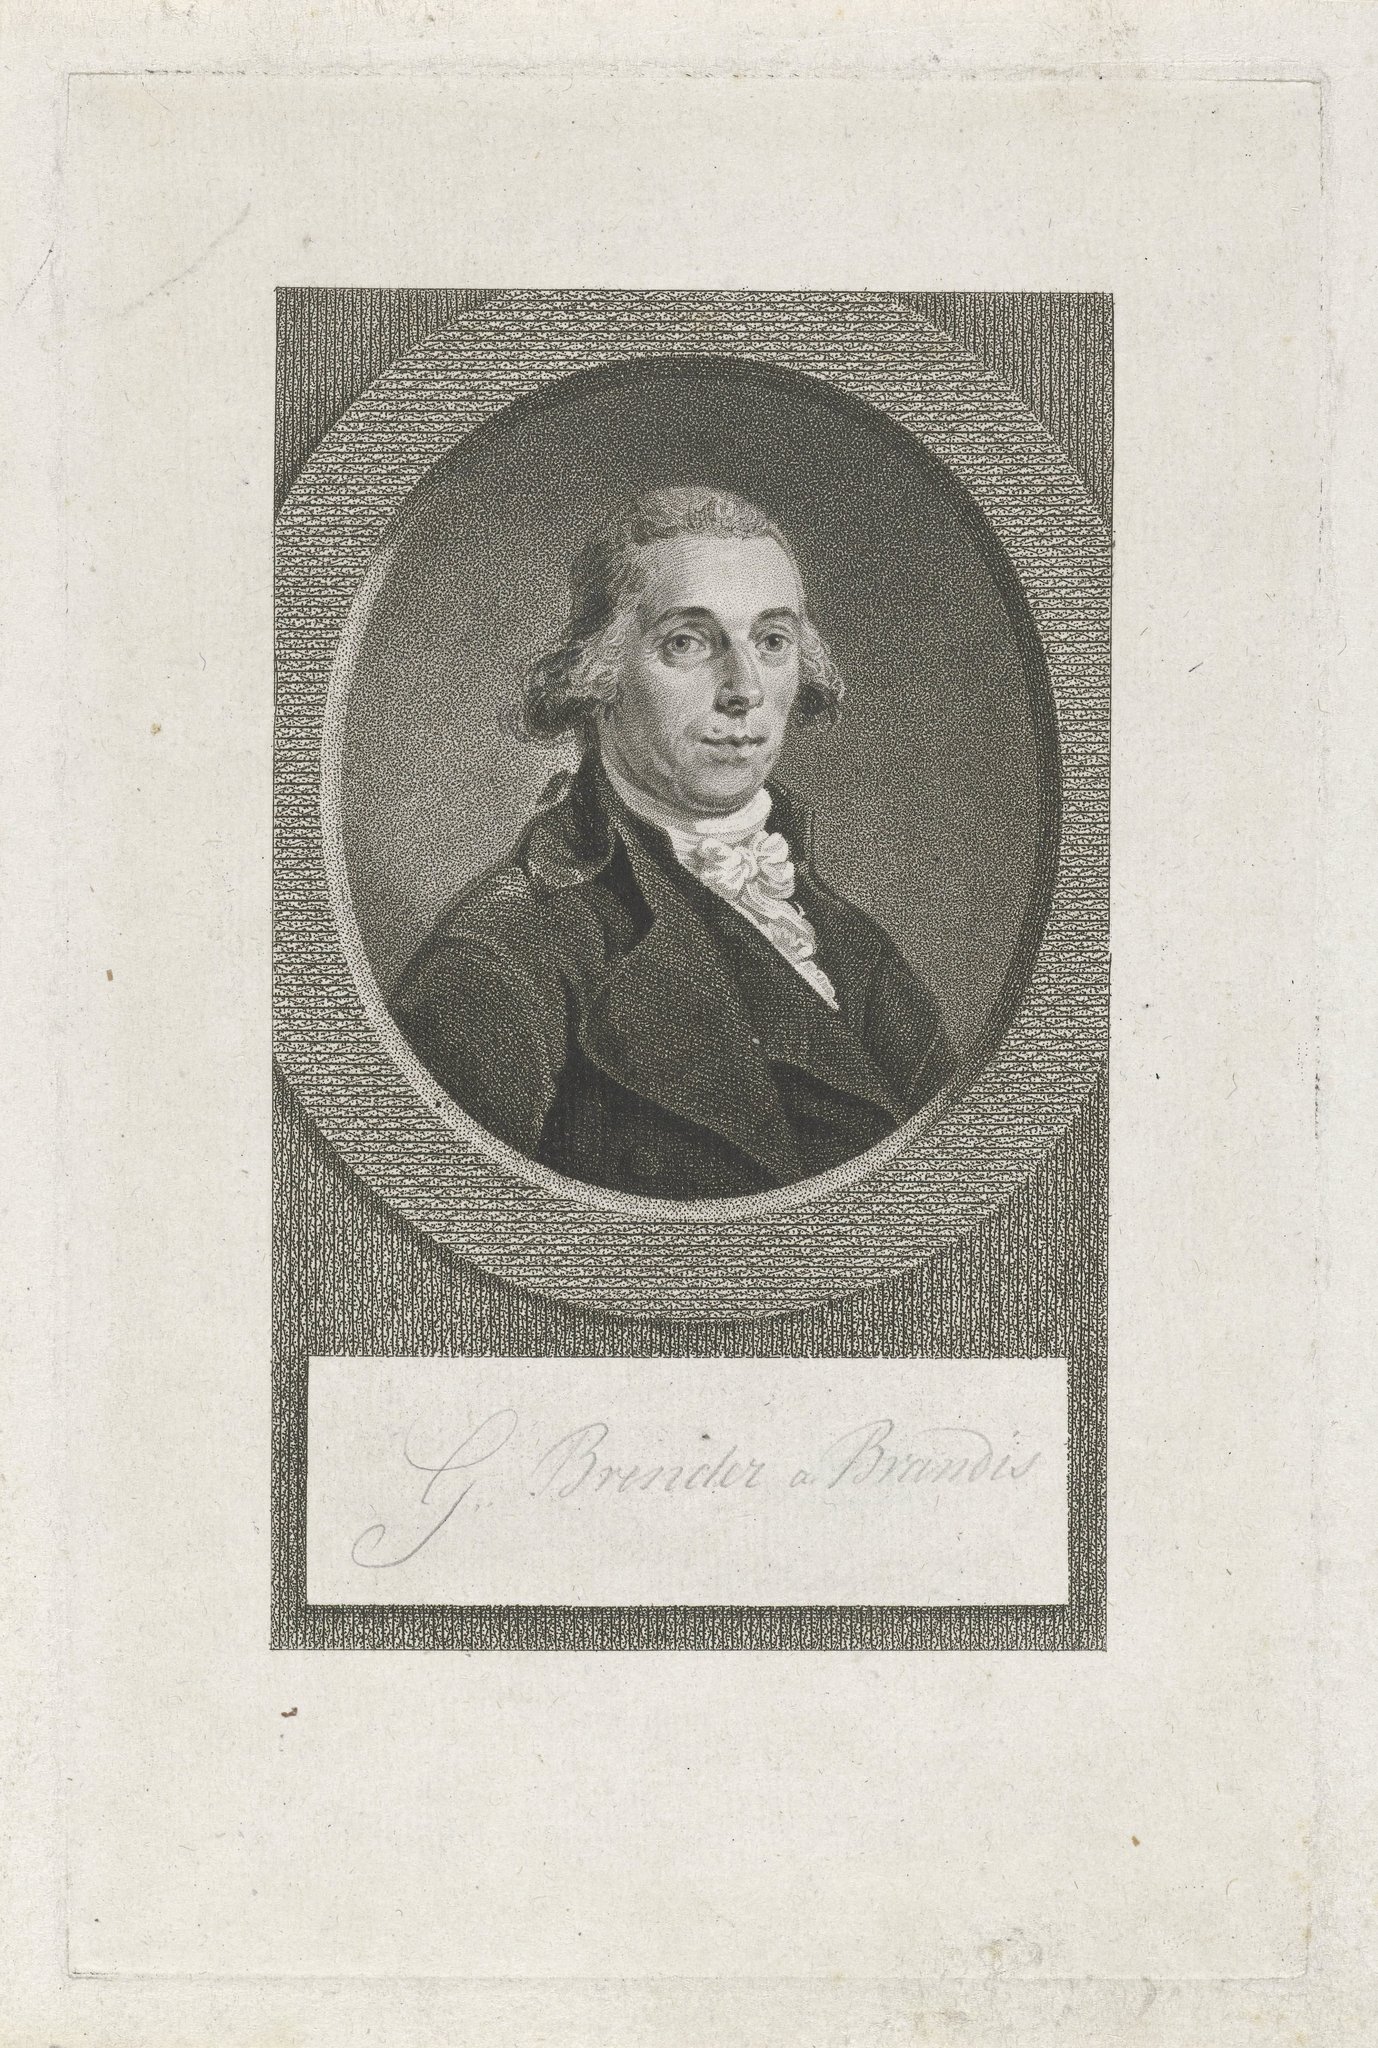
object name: print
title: Portret van Gerrit Brender à Brandis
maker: a. de lely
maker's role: painter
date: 1784-1828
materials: paper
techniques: etching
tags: leiden, amsterdam, gerrit brender à brandis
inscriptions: collector's mark: Lugt 2228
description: Busteportret van Gerrit Brender à Brandis. Het portret is gevat in een ovale omlijsting. Met een leeg kader.